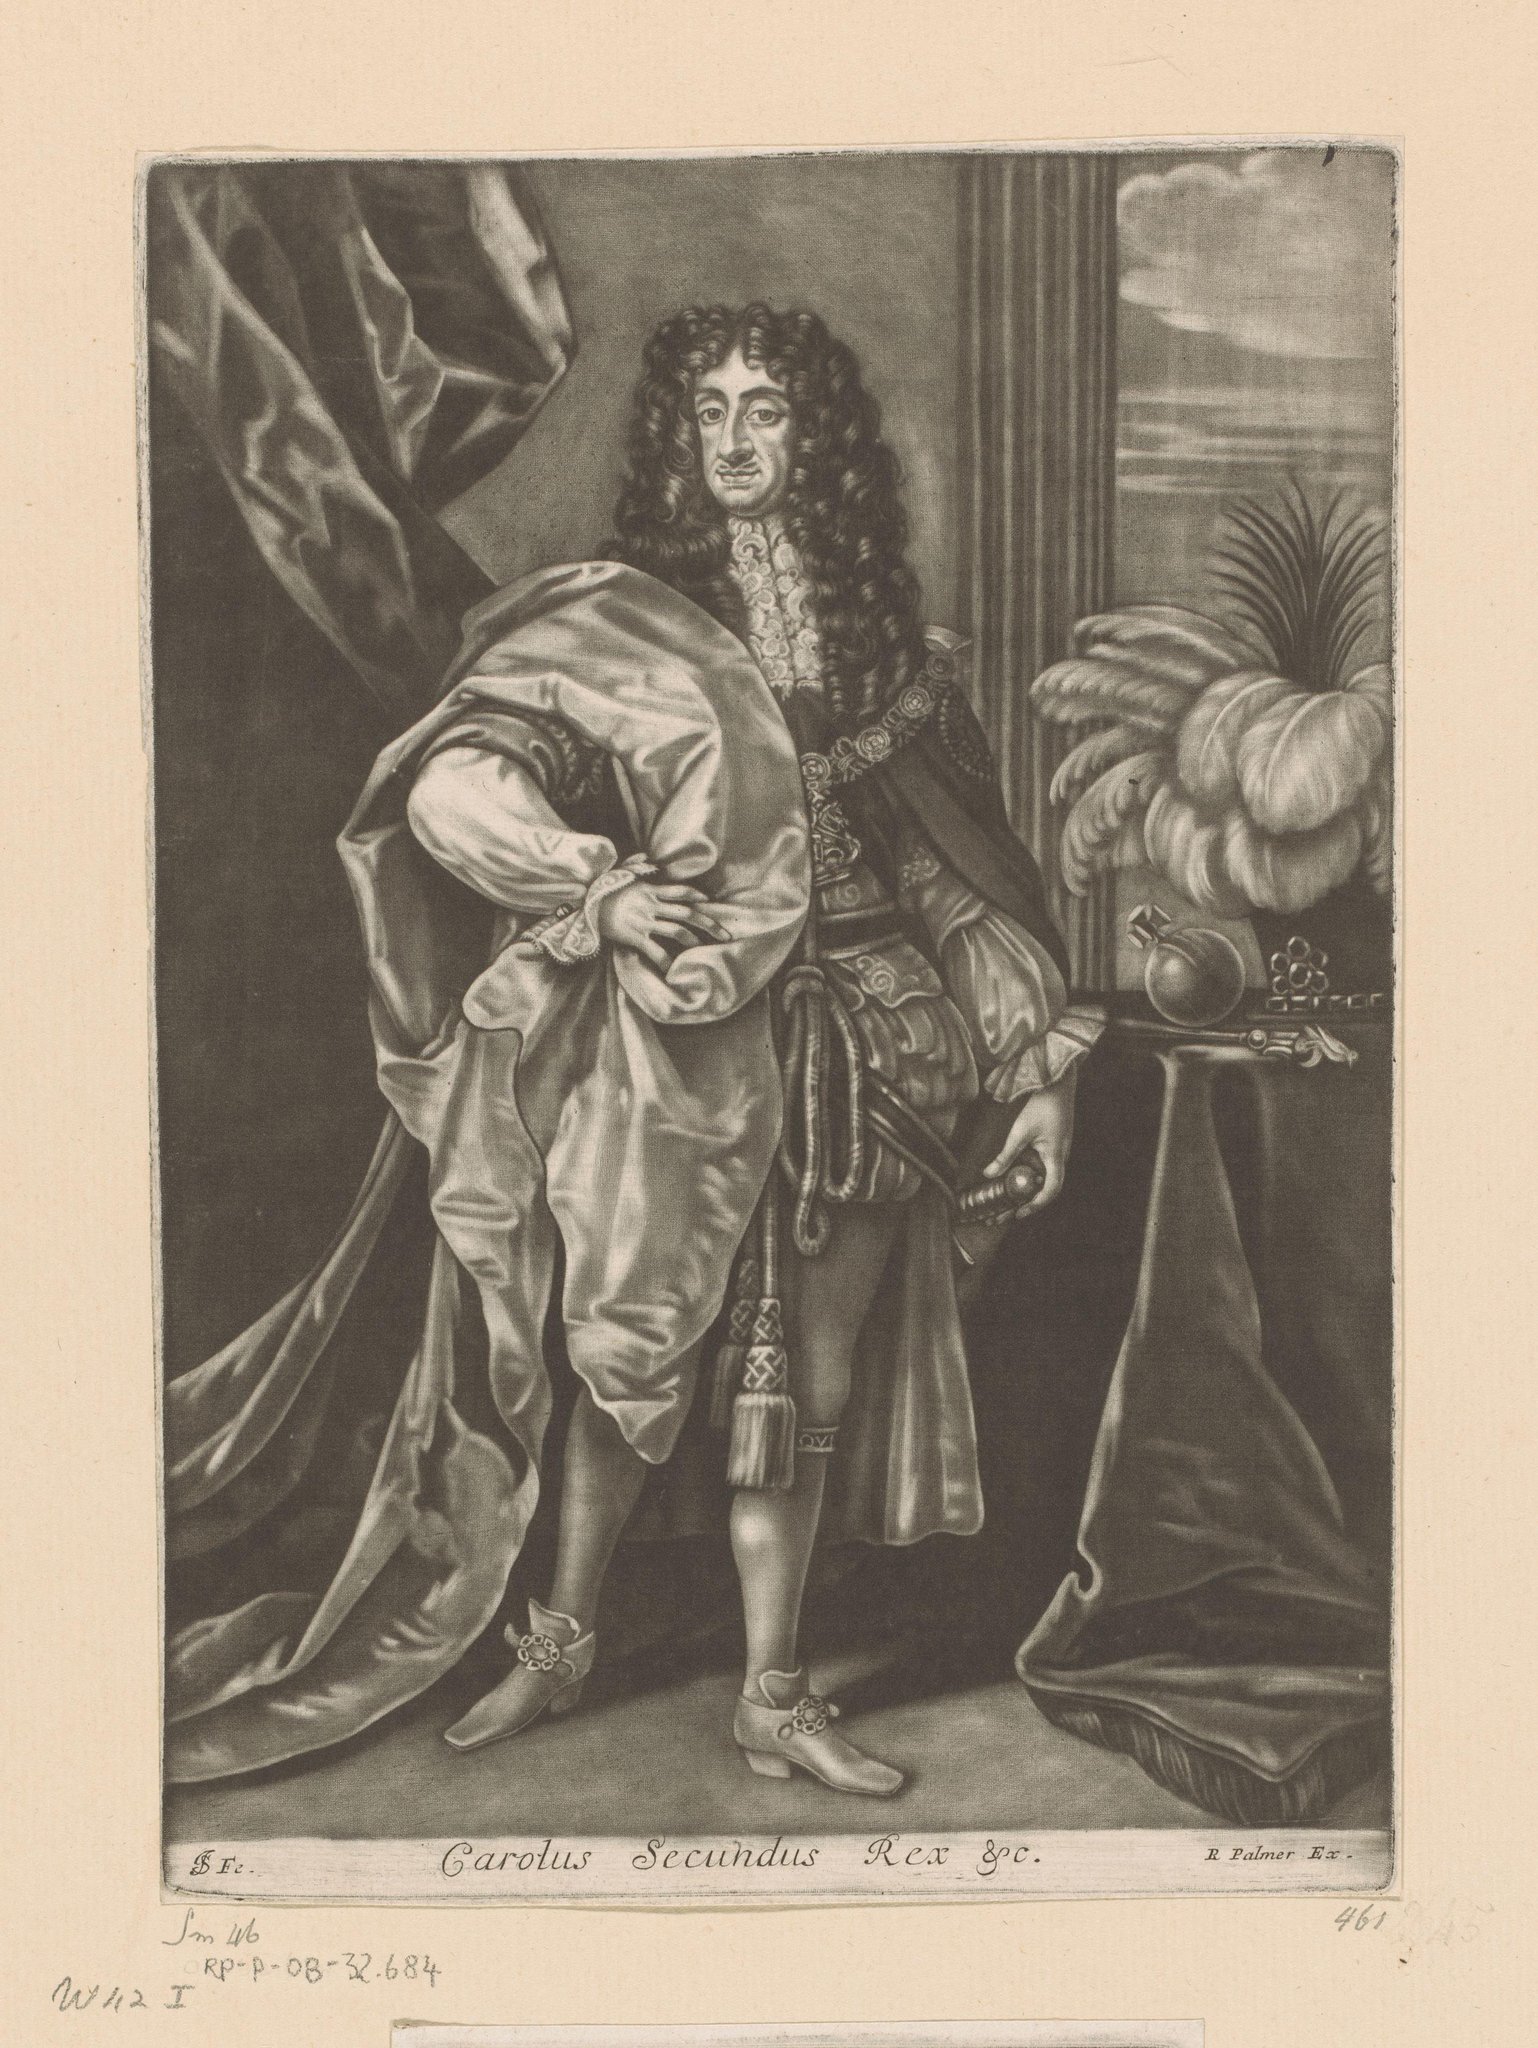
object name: print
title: Portret van Karel II, koning van Engeland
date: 1662-1742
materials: paper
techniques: mezzotint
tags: karel ii (koning van engeland), historical persons, king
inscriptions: collector's mark: Lugt 240